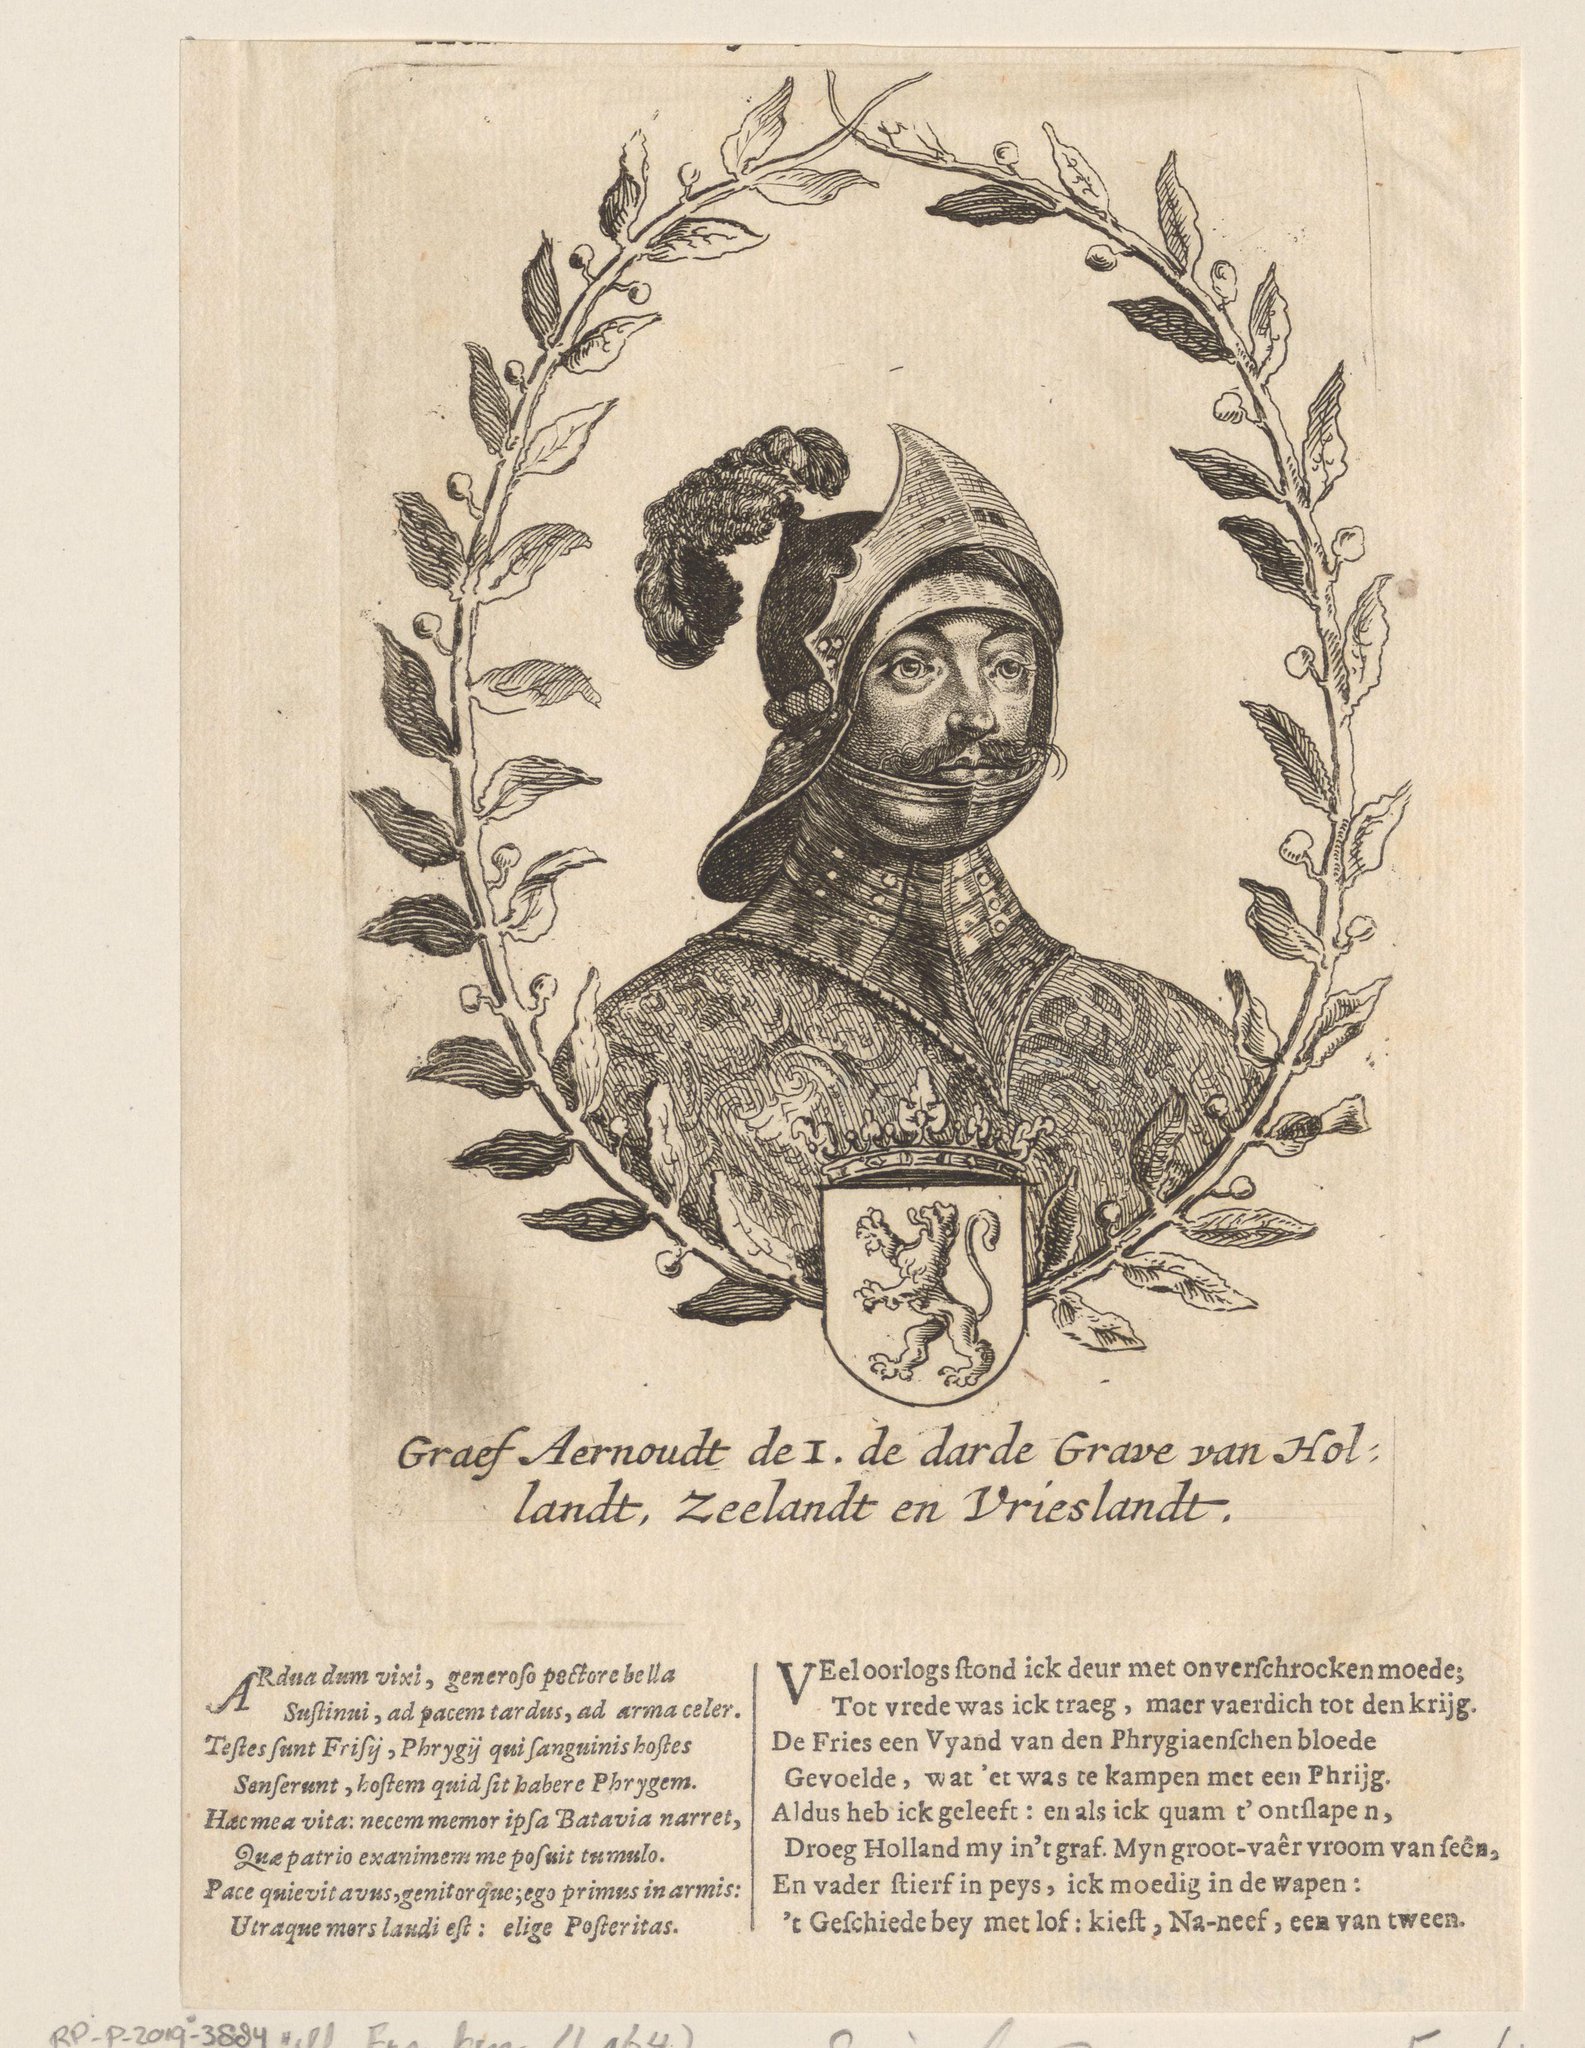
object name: book illustration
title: Portret van Arnulf, graaf van Holland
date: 1678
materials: paper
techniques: etching, letterpress printing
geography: the hague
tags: ghent, earl, armour, historical persons, armorial bearing, heraldry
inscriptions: collector's mark: Lugt 964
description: Prent uit: Scriverius, Petrus. Hollandsche, Zeelandsche ende Vriesche chronyck. Den Haag: Jasper Doll en Johan Veely, 1678, p. 39.